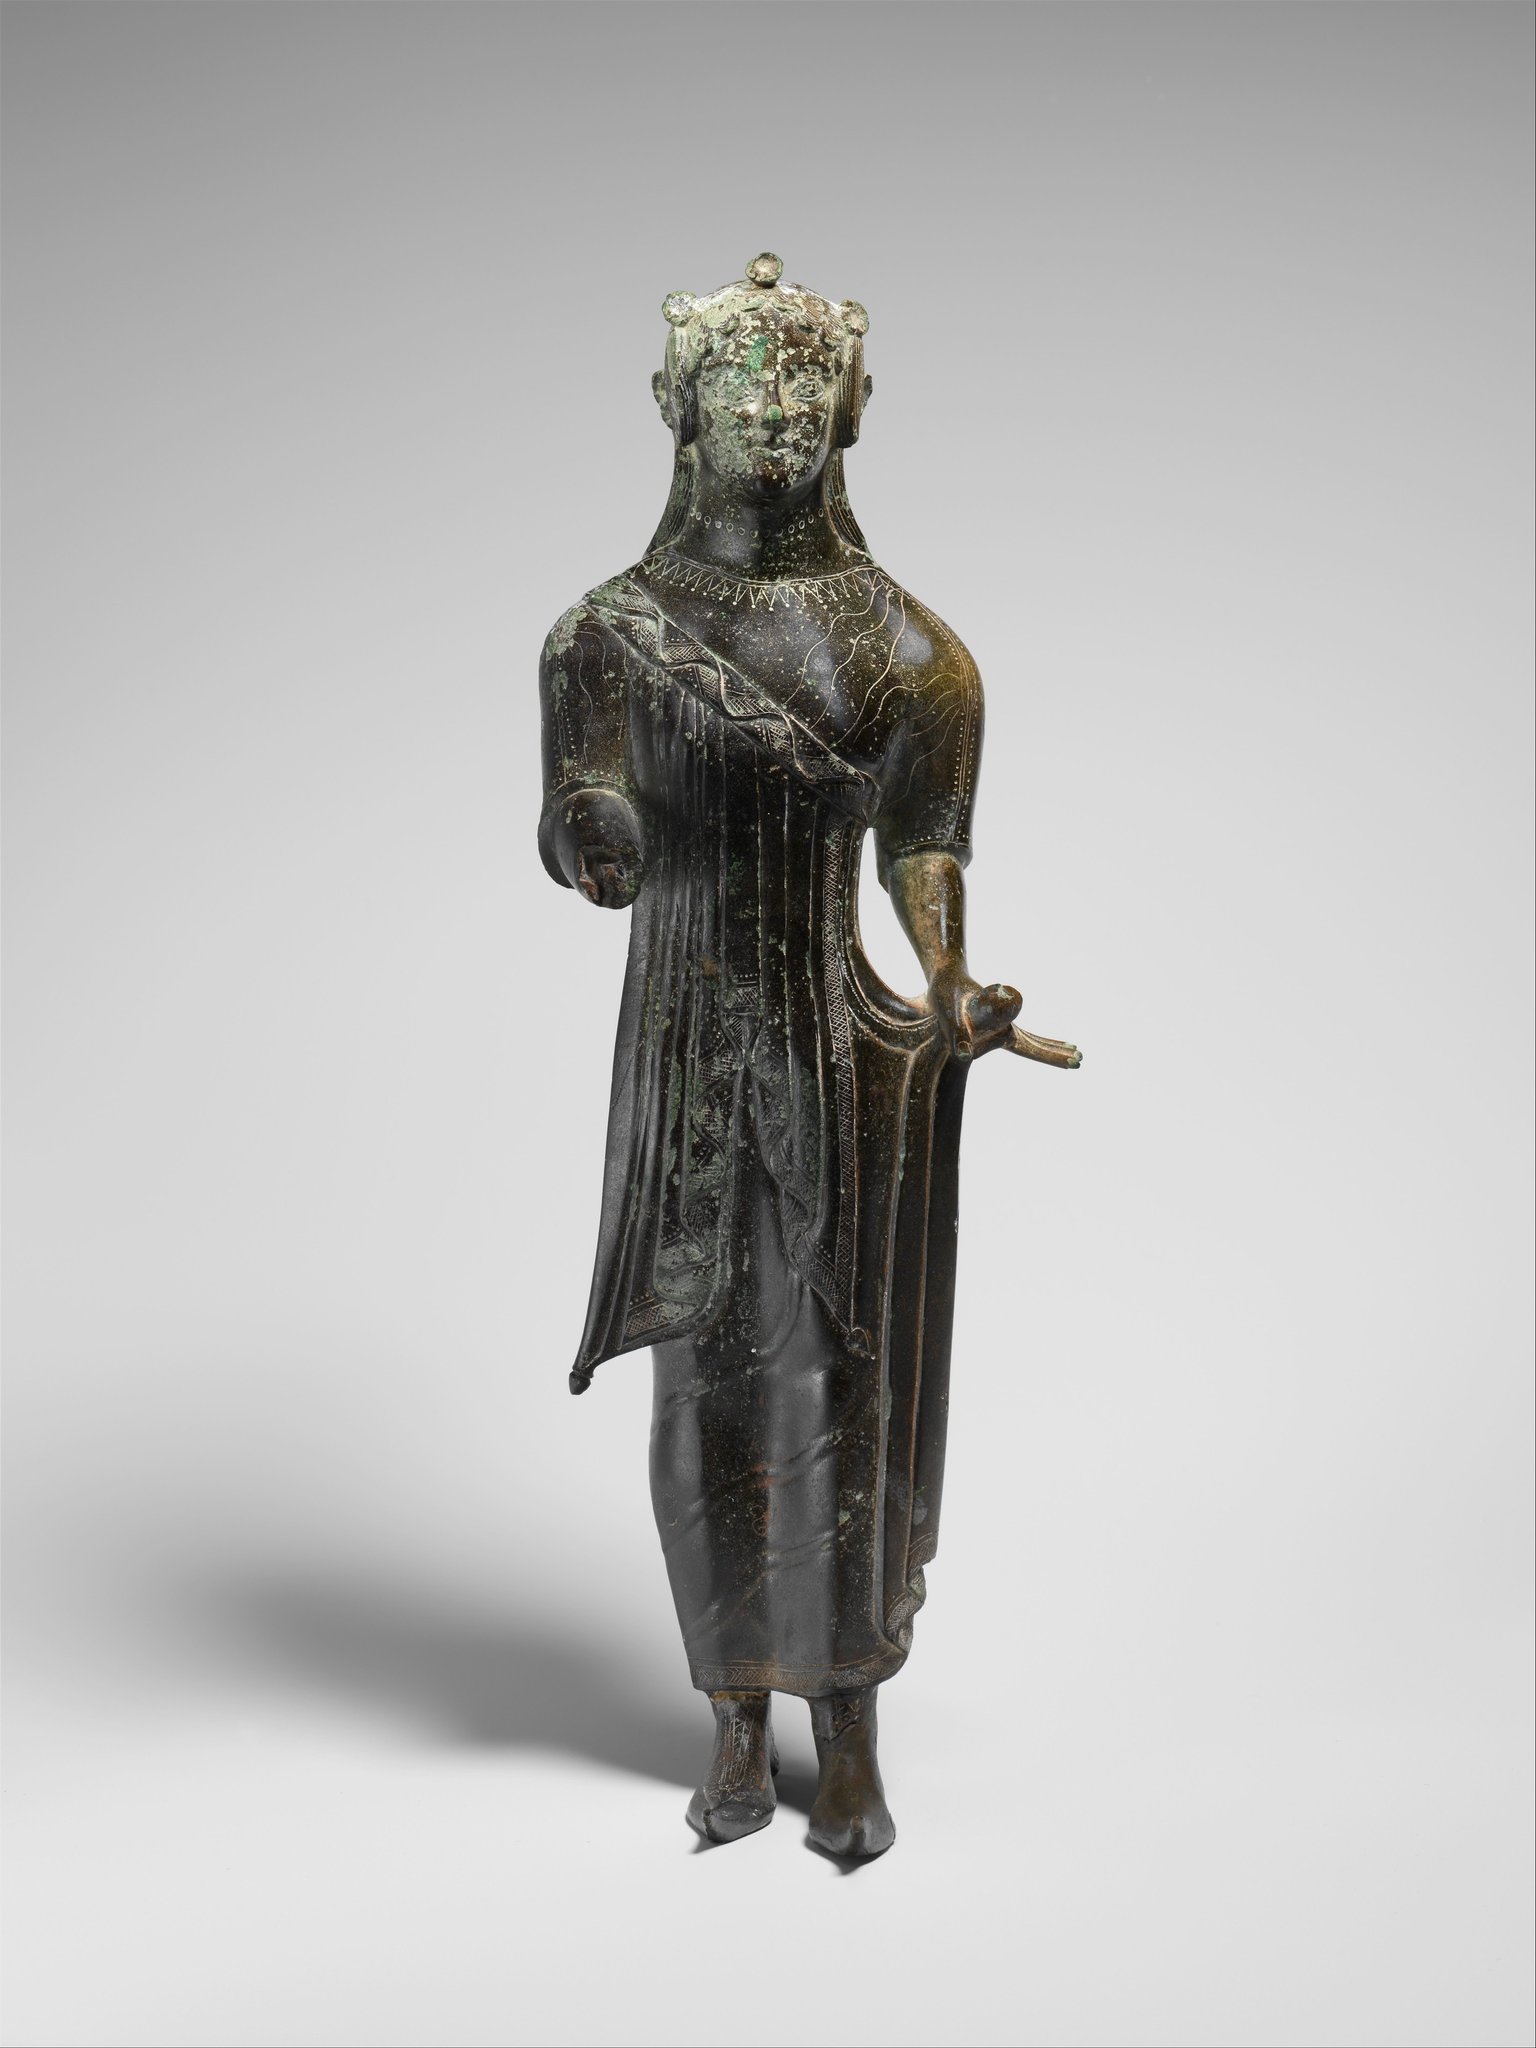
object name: statue of a young woman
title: Bronze statuette of a young woman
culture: etruscan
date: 534-501 BCE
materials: bronze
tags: women